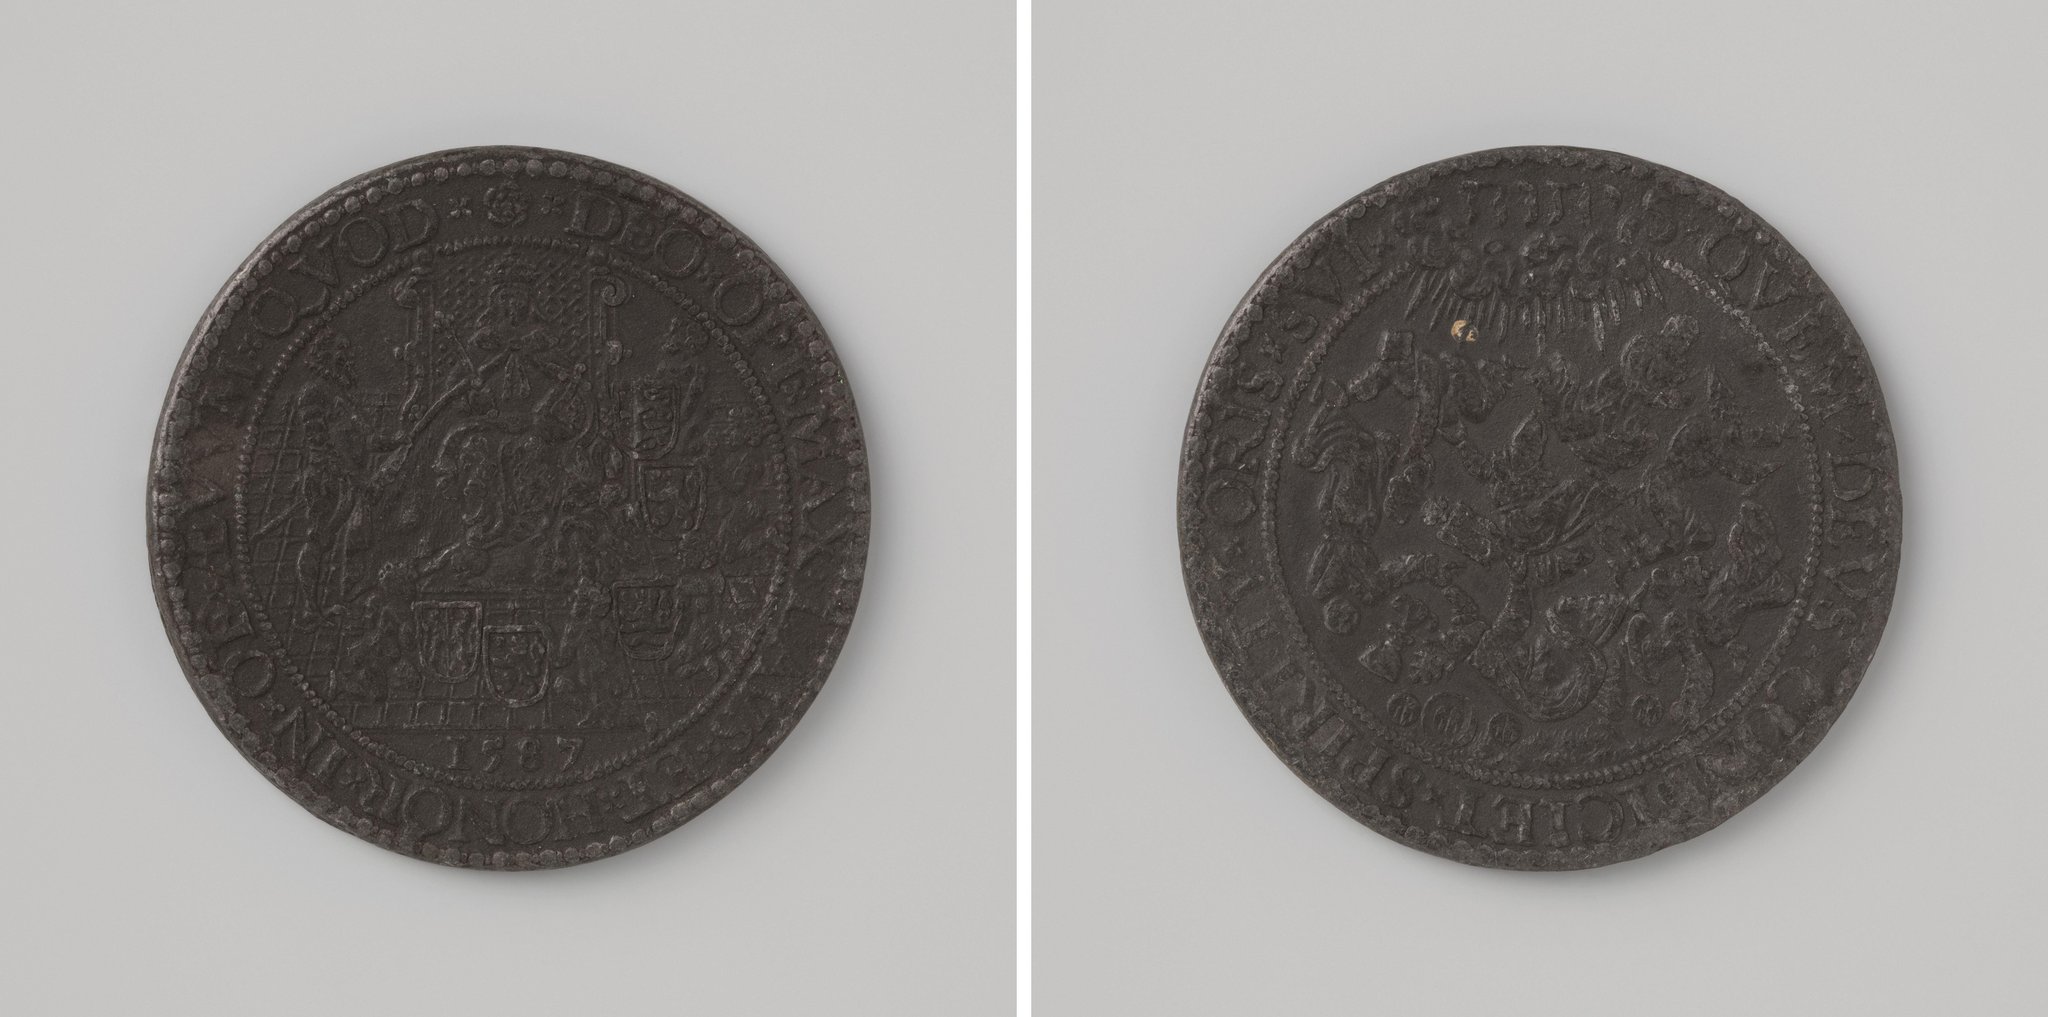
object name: history medal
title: De graaf van Leicester als beschermheer van de protestanten 1587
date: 1587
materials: tin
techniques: casting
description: Tinnen penning, op de voorzijde de graaf van Leicester die de Nederlandse gewesten bescherming aanbiedt in de vorm van de mantel van de getroonde Elisabeth van Engeland, met omschrift, op de keerzijde Paus en geestelijken die de hemel ontvallen, met omschrift